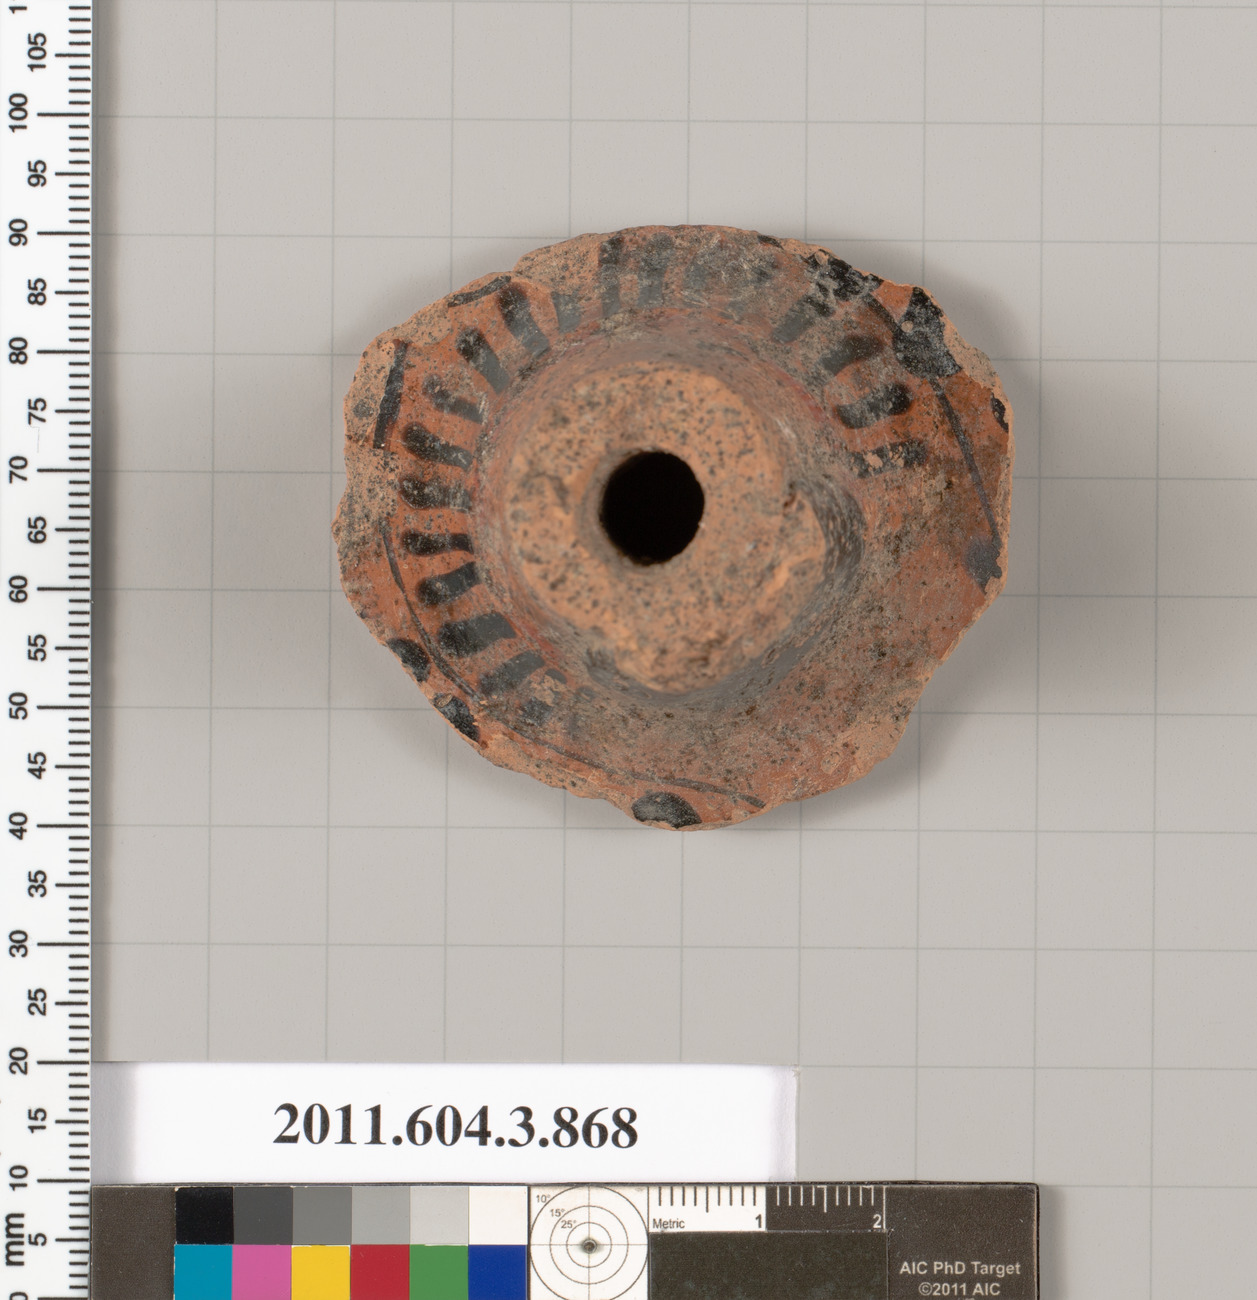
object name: lekythos fragment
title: Terracotta fragment of a lekythos (oil flask)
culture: greek, attic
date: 534-501 BCE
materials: terracotta